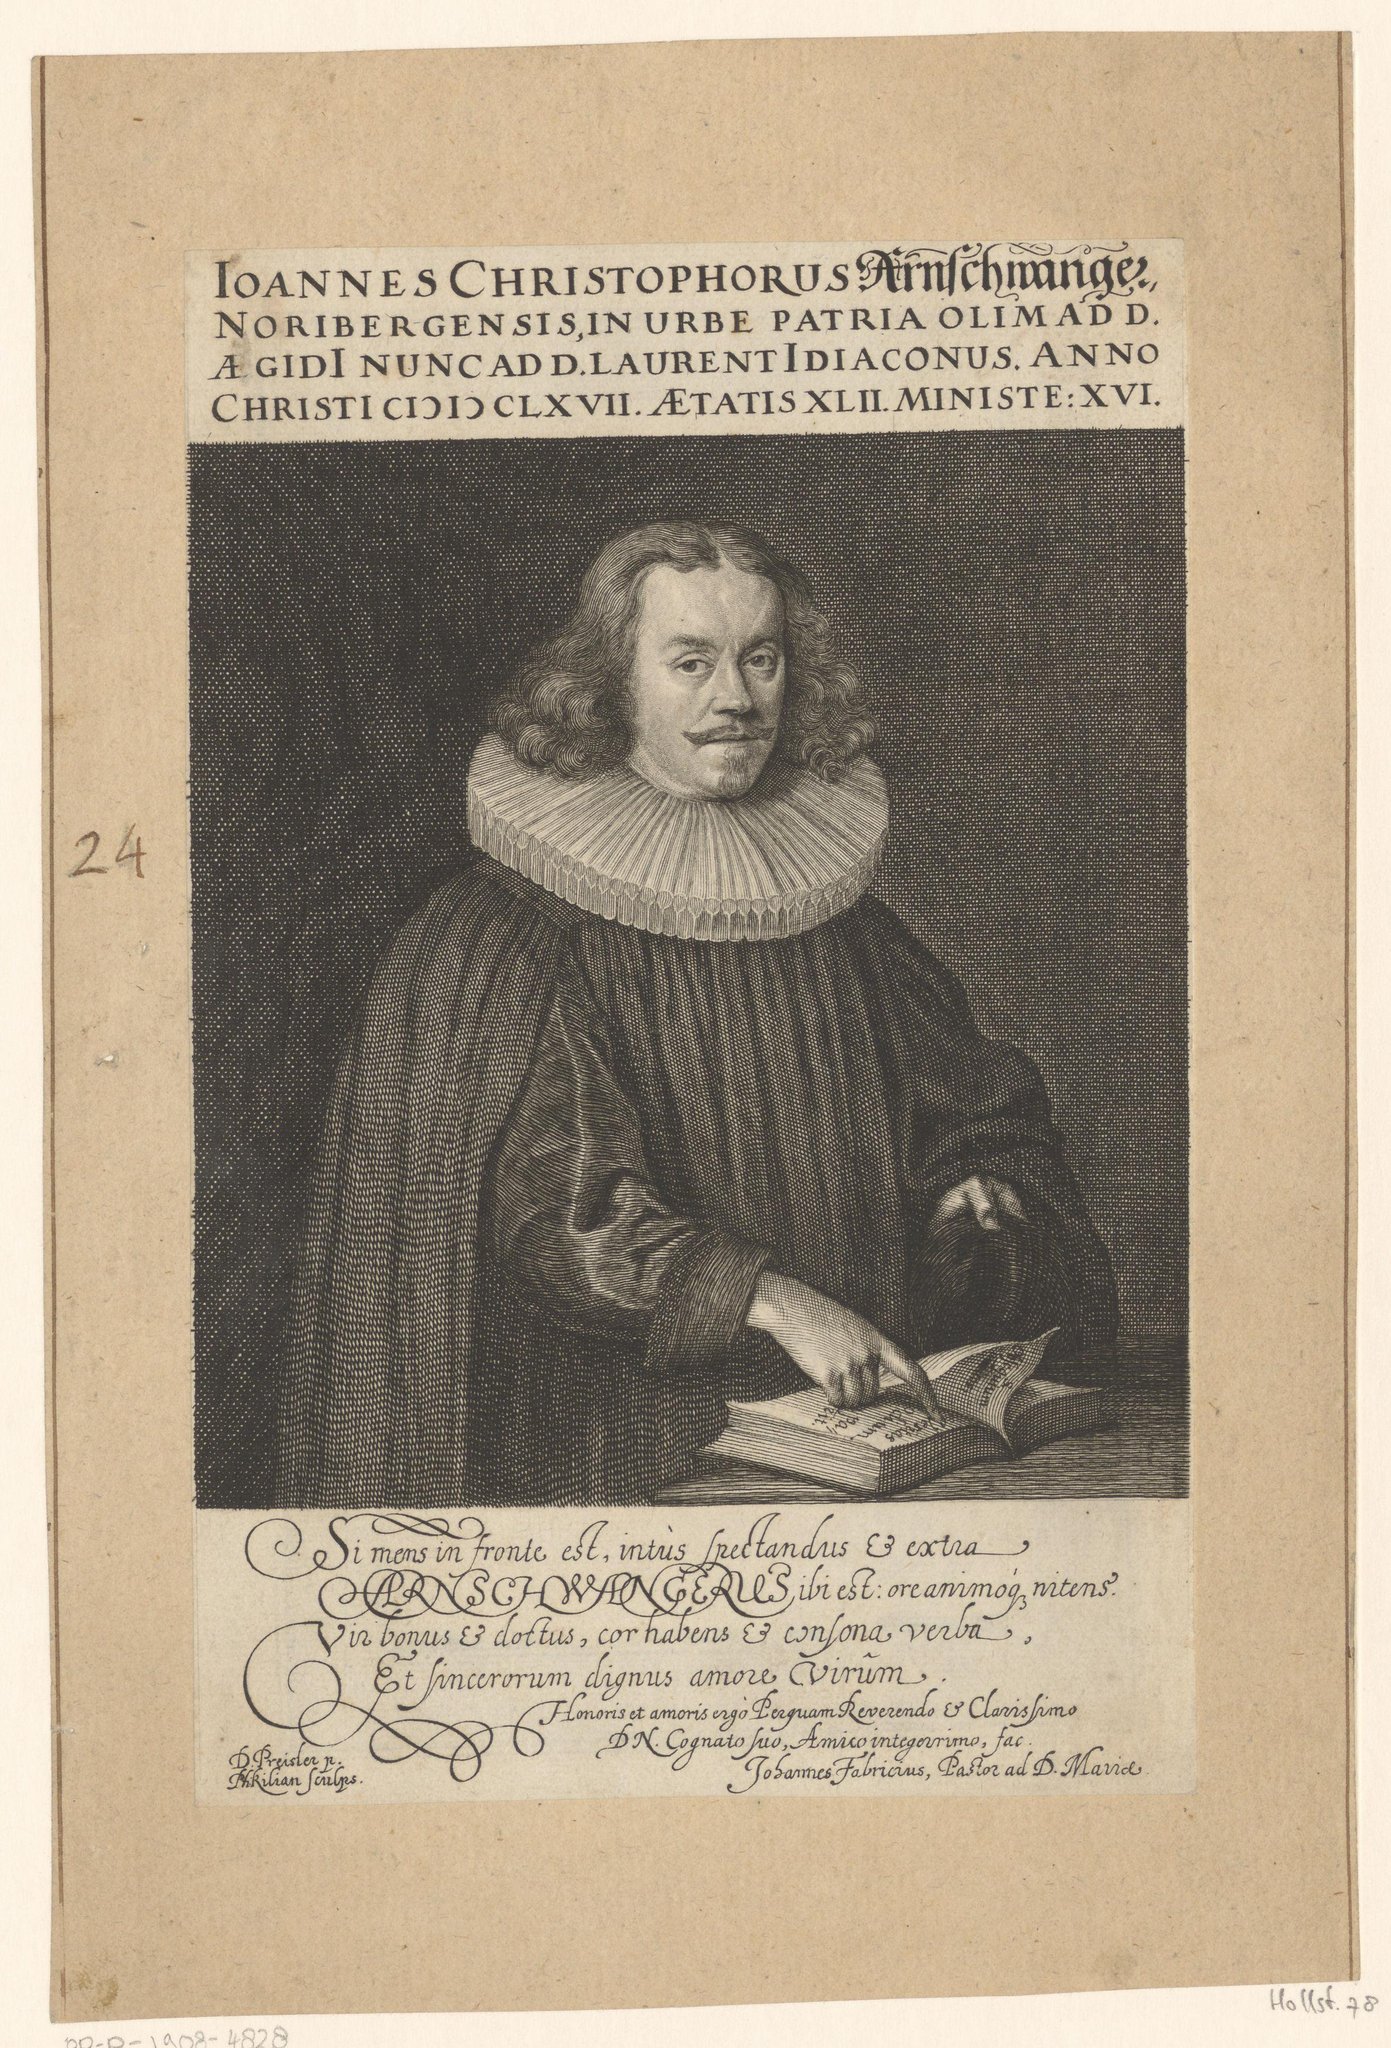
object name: print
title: Portret van Johann Christoph Arnschwanger op 56-jarige leeftijd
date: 1638-1693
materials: paper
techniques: engraving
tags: clergyman, johann christoph arnschwanger, theologian, historical persons